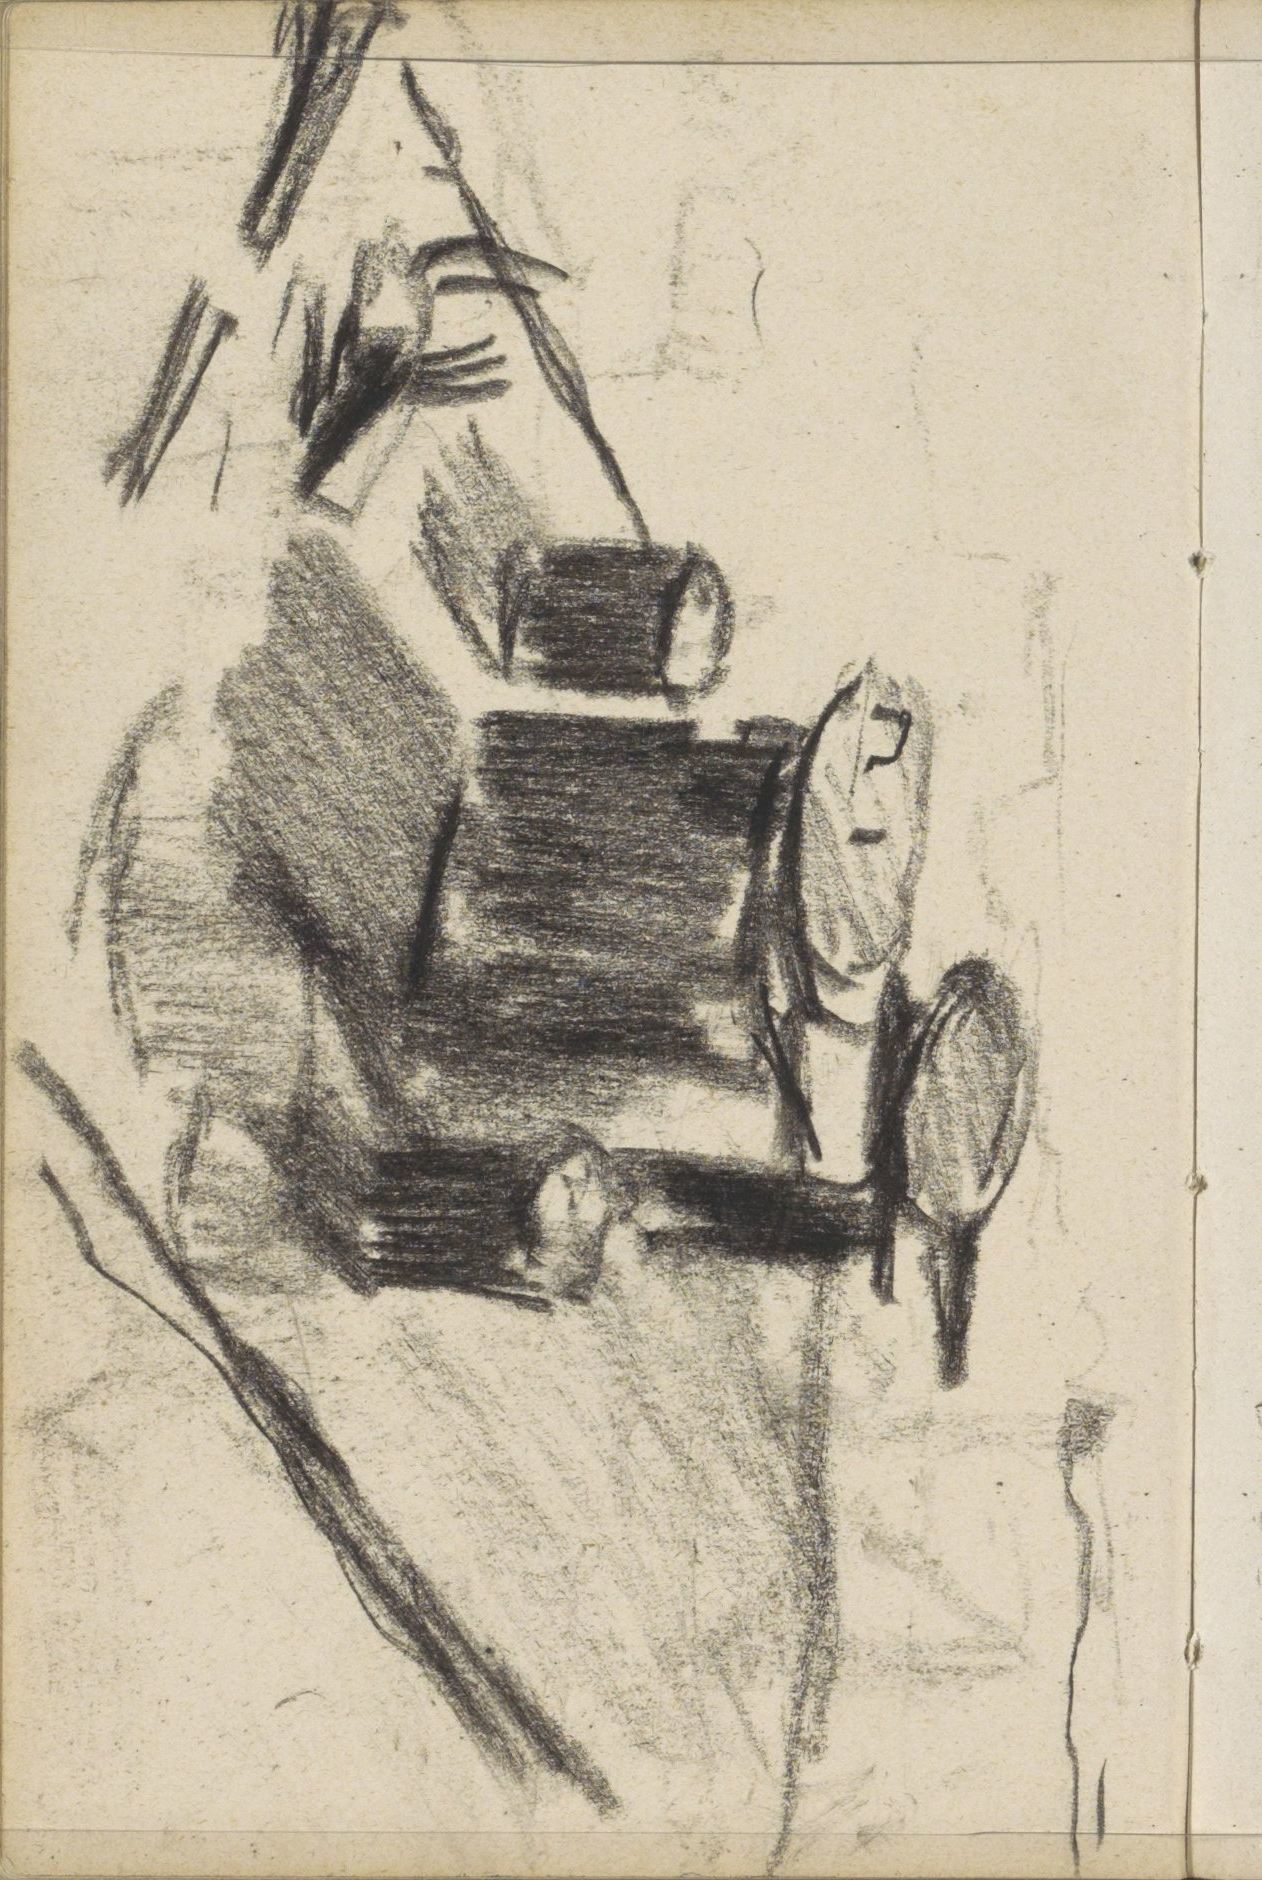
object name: sketchbook leaf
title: Studie, mogelijk van meerpalen of emmers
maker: george hendrik breitner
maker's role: draughtsman, painter, print maker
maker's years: 1857-1923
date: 1909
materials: chalk, paper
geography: amsterdam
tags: mooring-buoy, bollard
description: Studie, mogelijk van meerpalen of emmers. In het laatste geval waarschijnlijk teeremmers uit de omgeving van de Prinseneilandsgracht te Amsterdam. Pagina 79 uit een schetsboek met 45 bladen vervaardigd in Amsterdam en Pittsburgh.